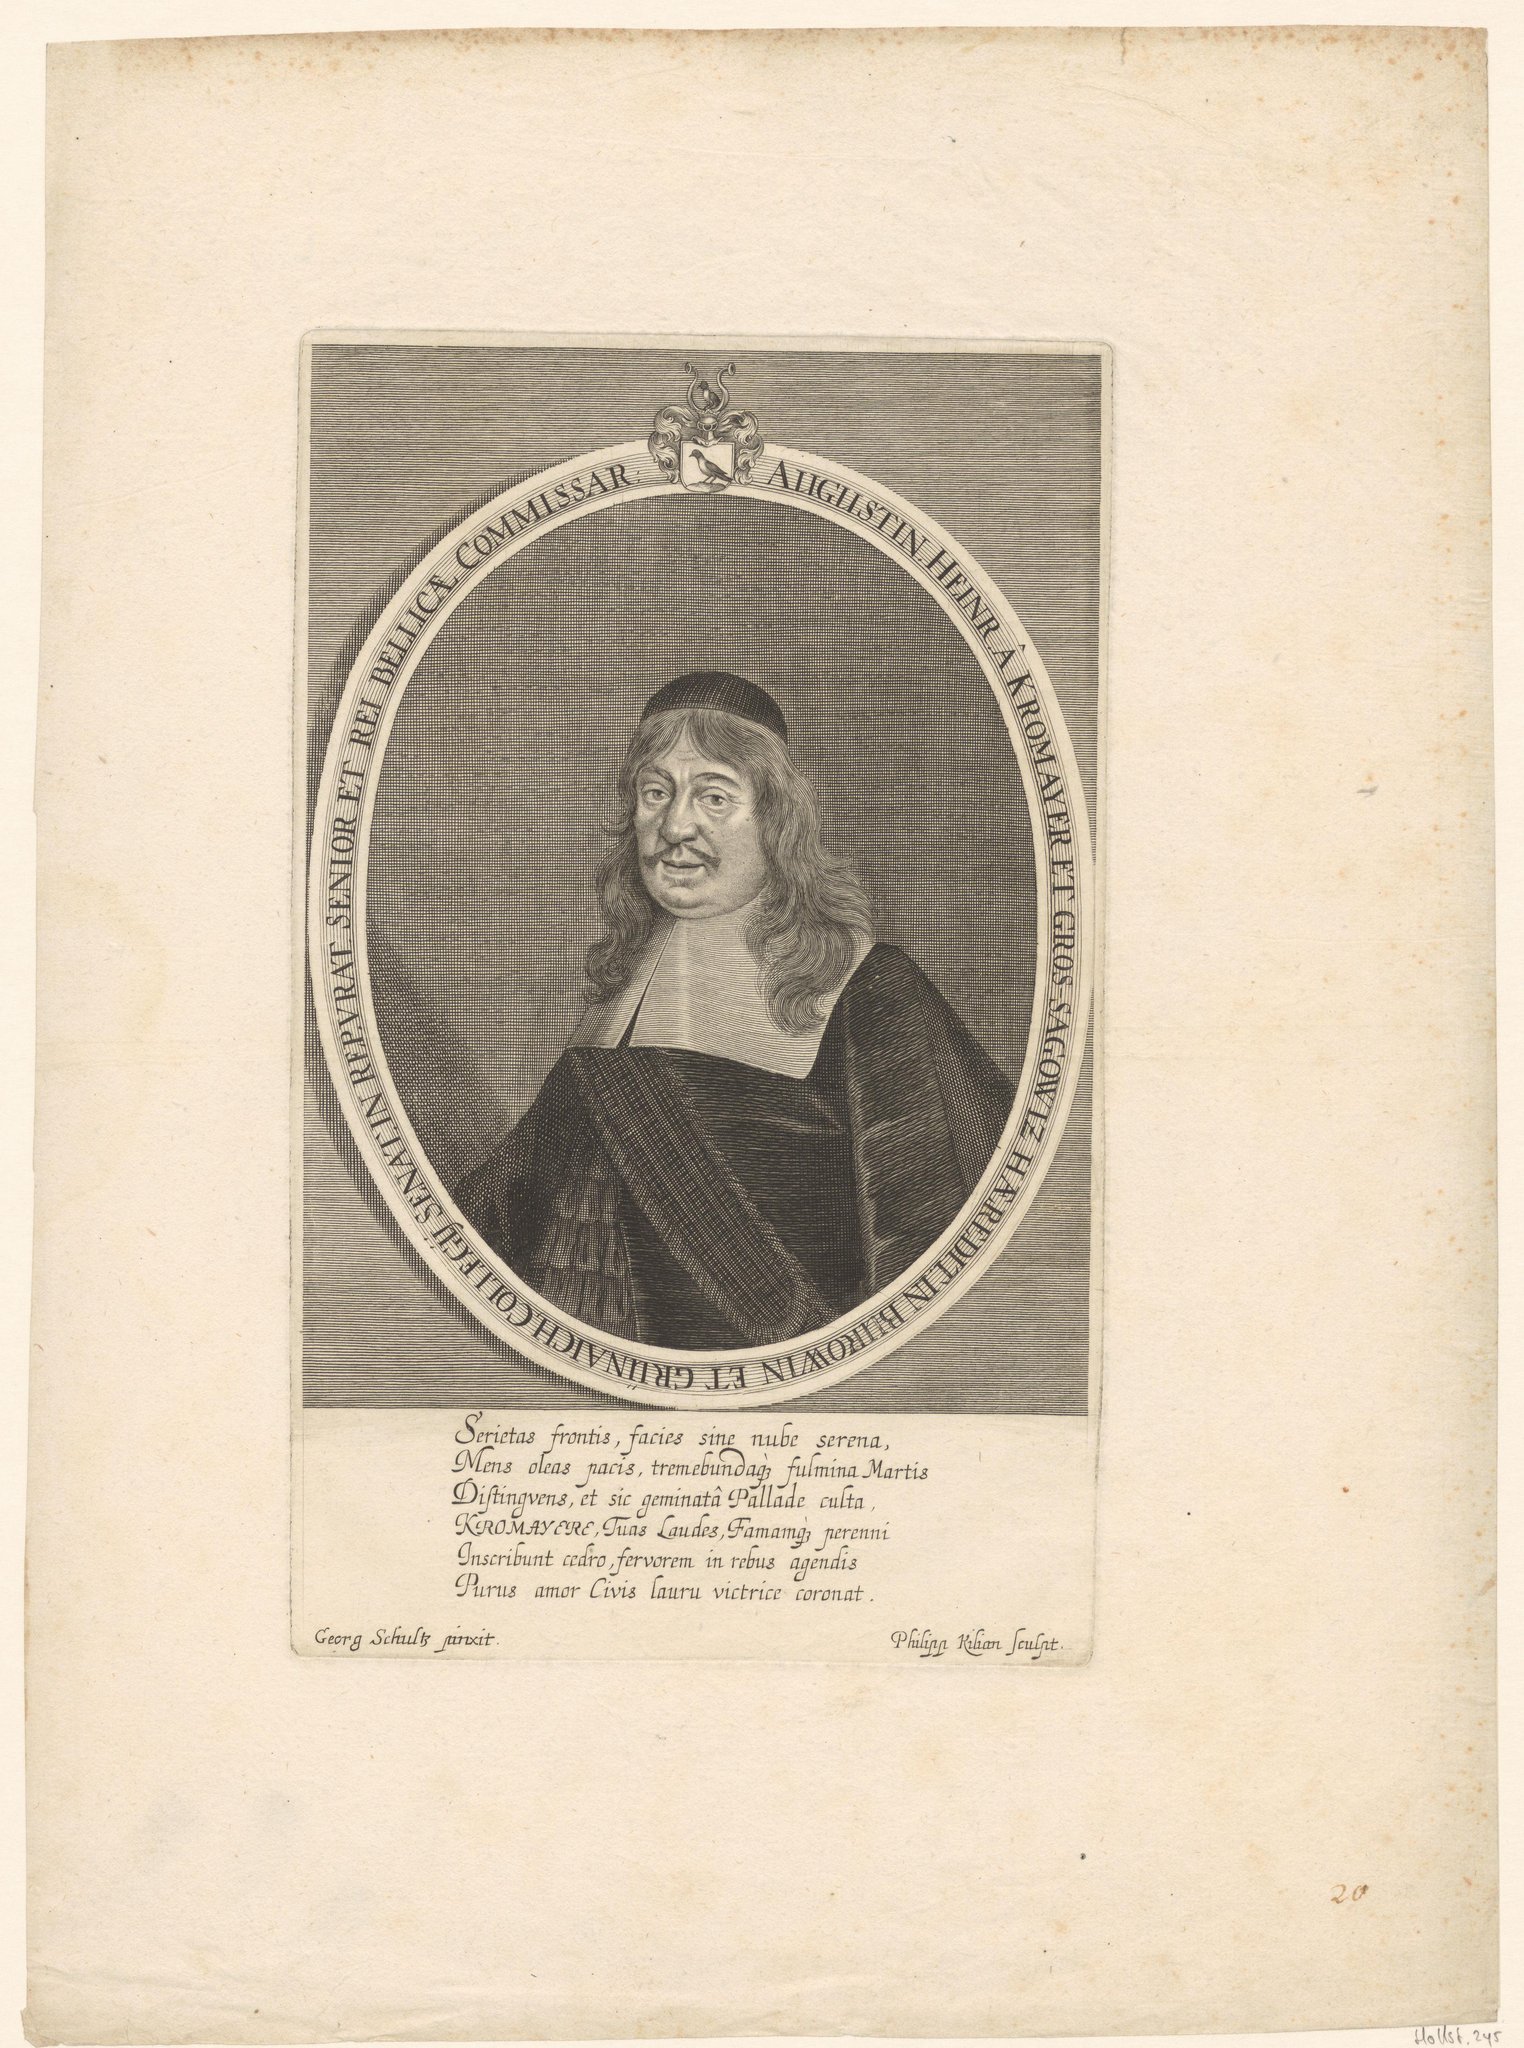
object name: print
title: Portret van Augustin Heinrich Kromayer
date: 1638-1693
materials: paper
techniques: engraving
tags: historical persons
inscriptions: collector's mark: Lugt 2228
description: Tekst in het Latijn in de omlijsting en in de ondermarge.